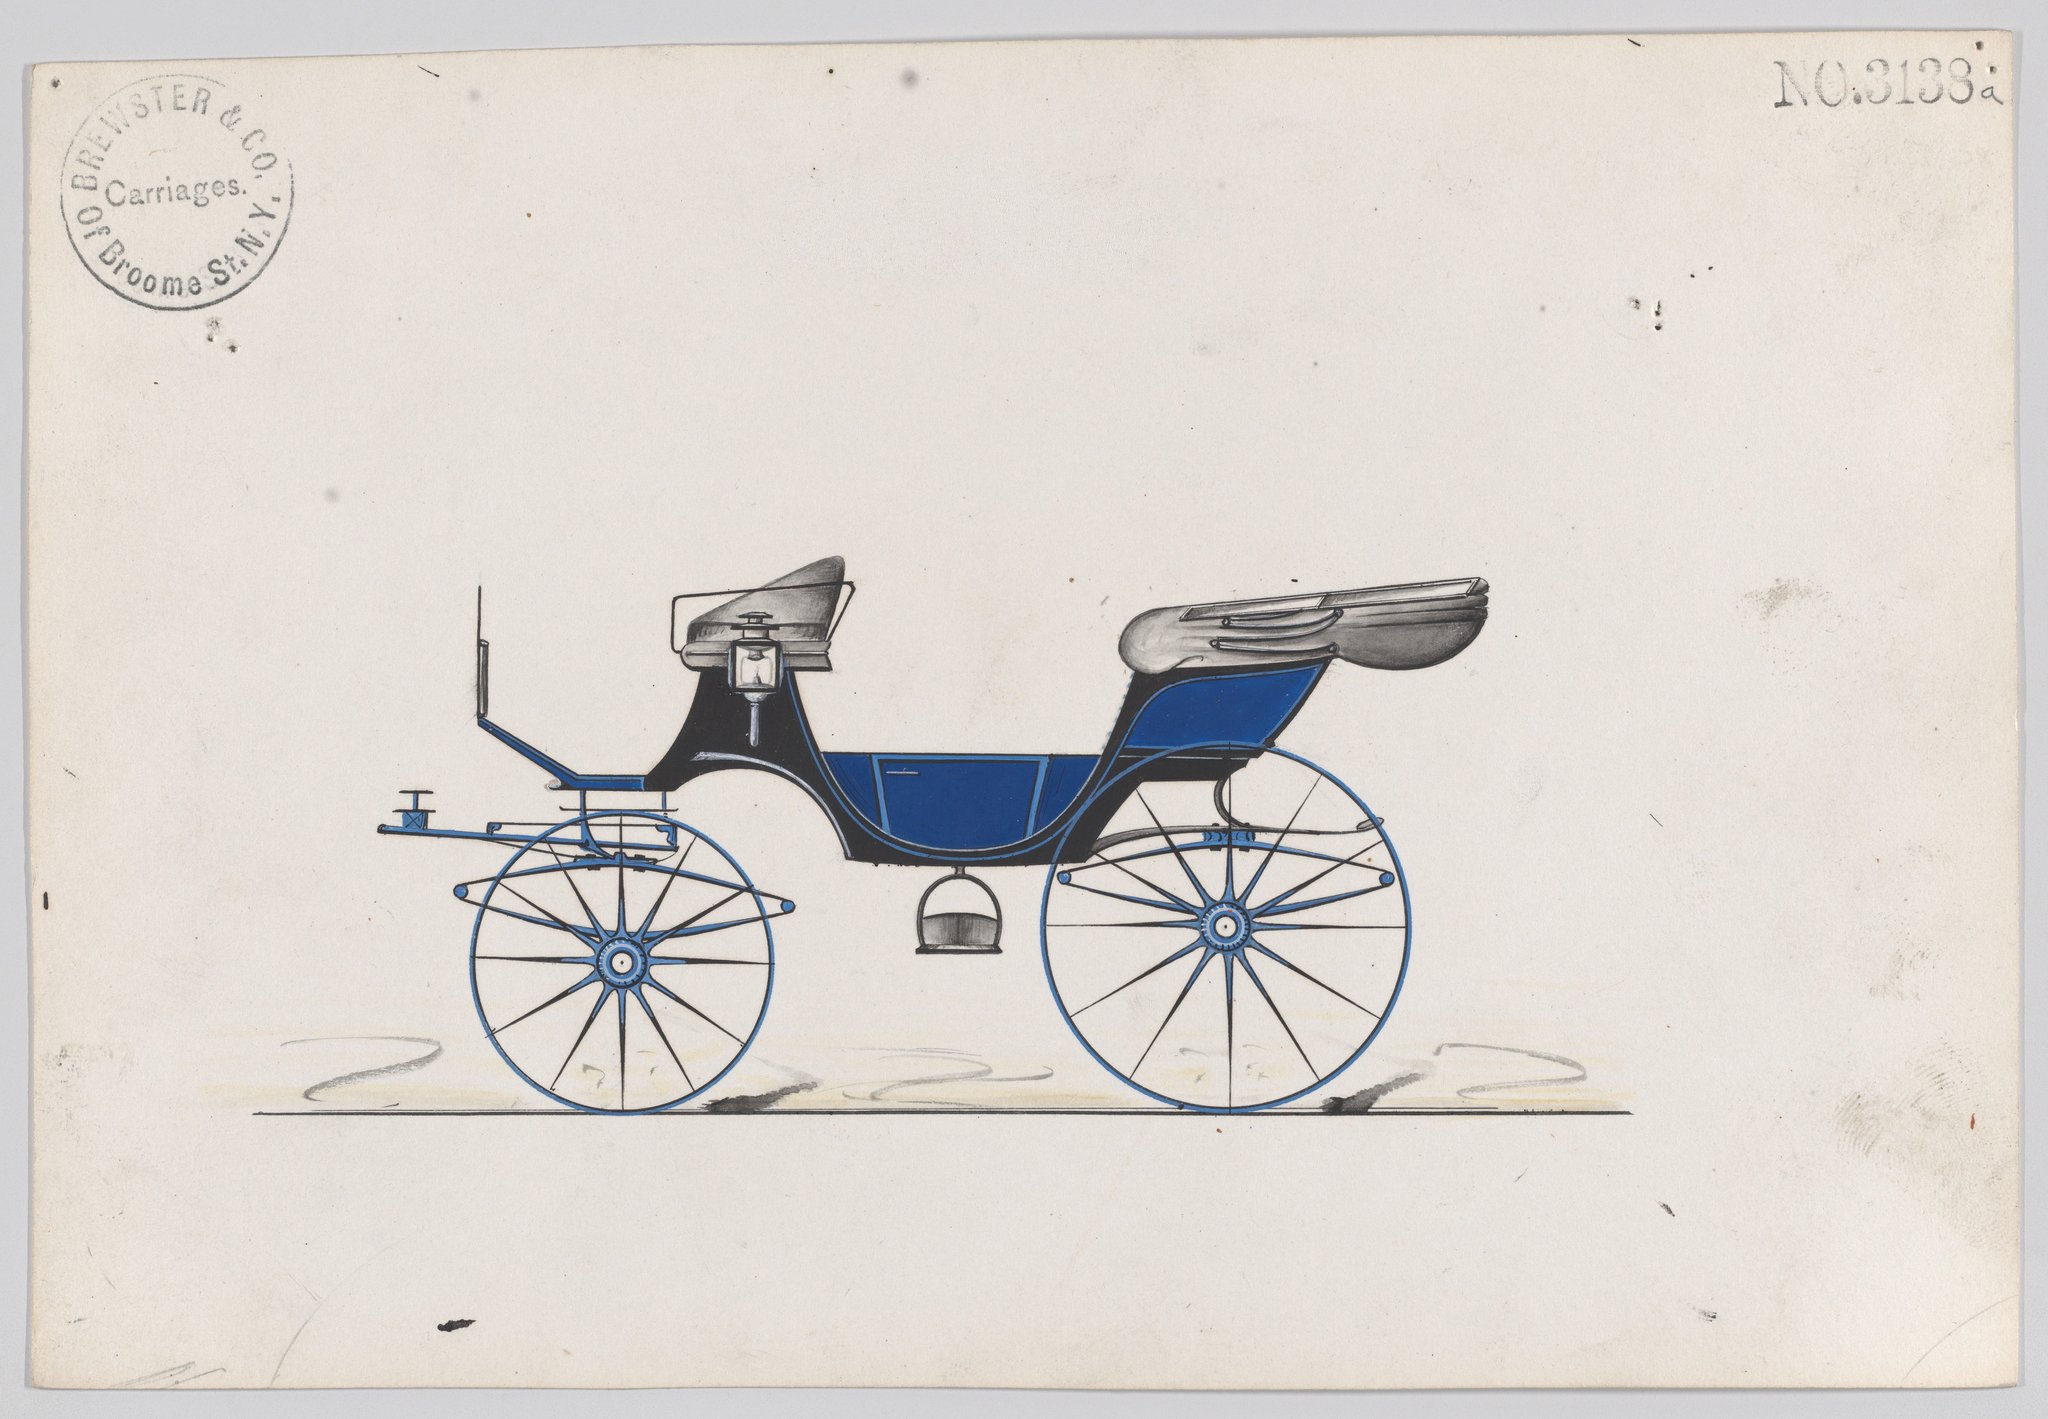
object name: drawing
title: Design for Cabriolet, no. 3138a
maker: brewster & co.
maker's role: manufacturer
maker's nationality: american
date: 1875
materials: gouache, ink, watercolor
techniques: pen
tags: carriages